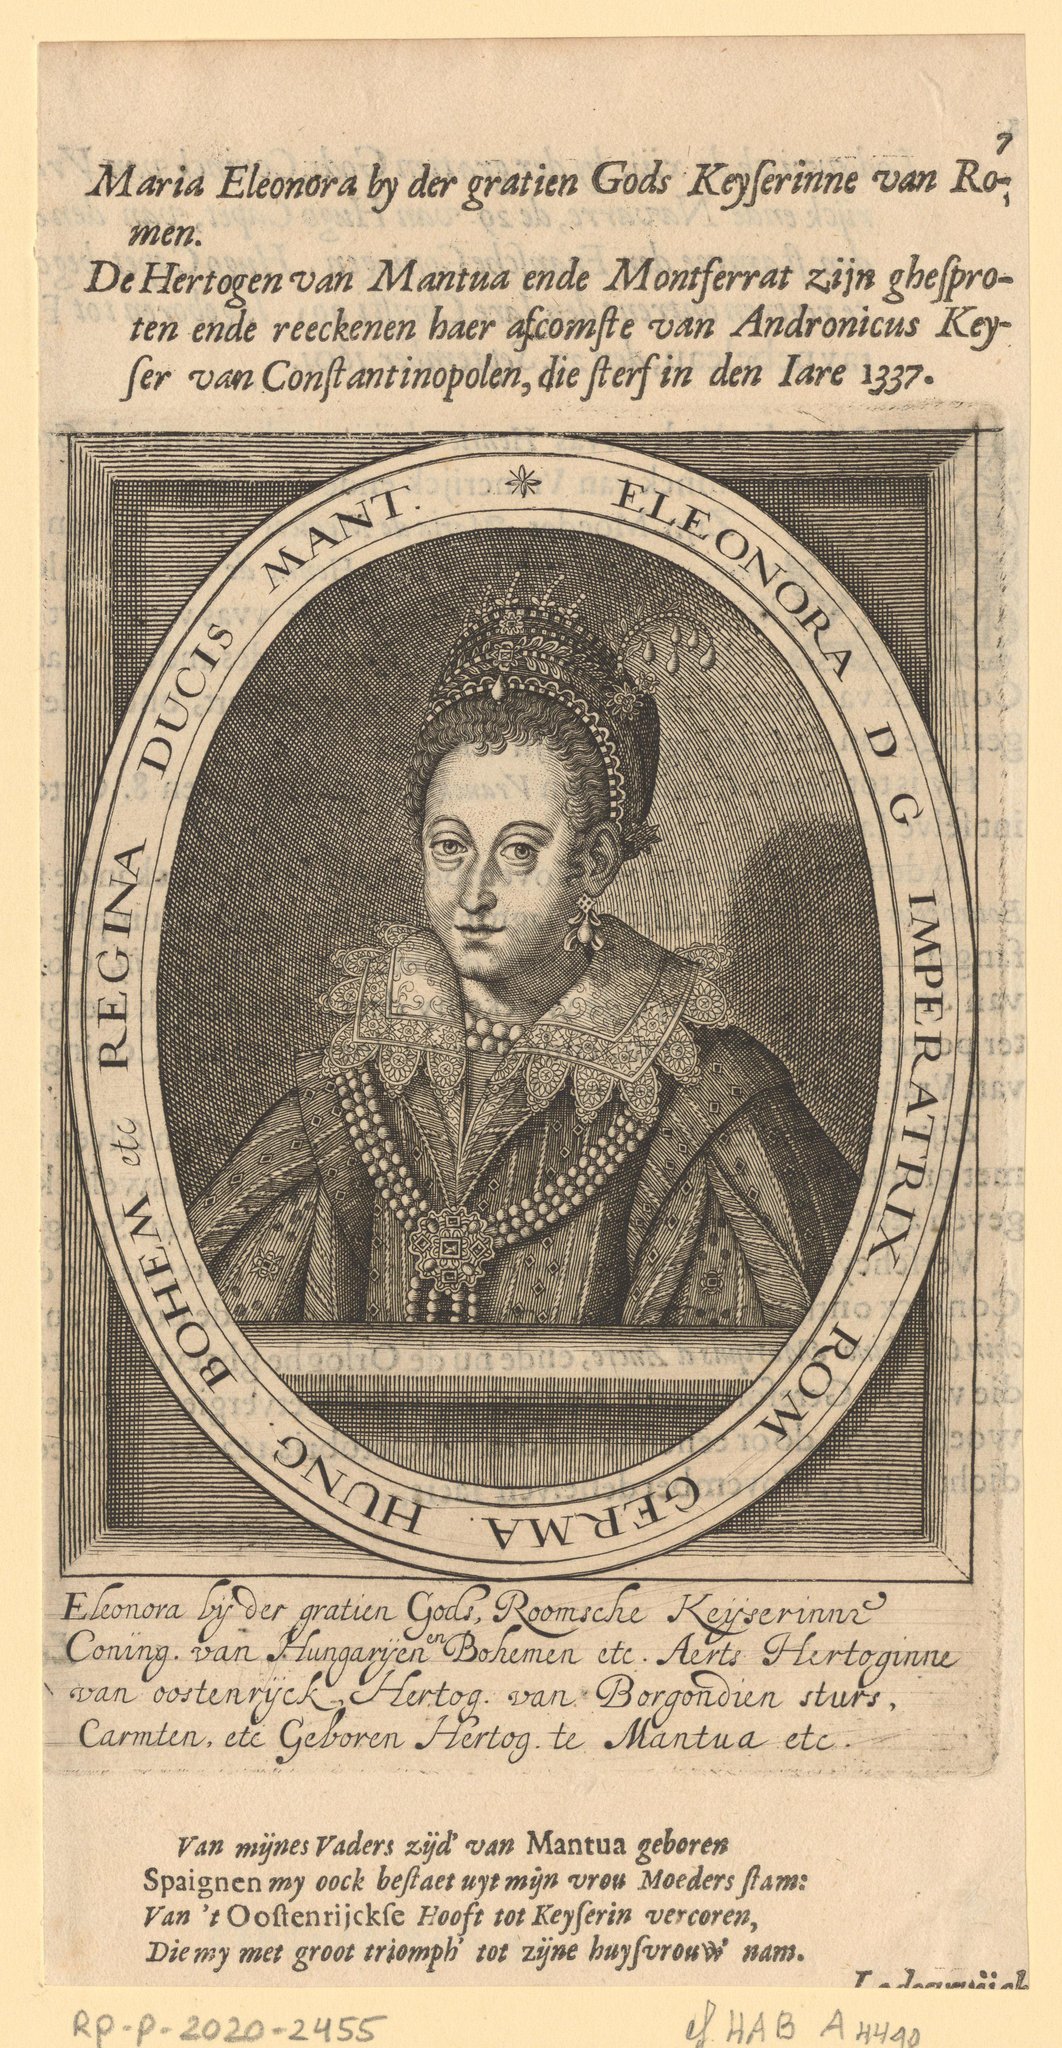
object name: book illustration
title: Portret van Eleonora Gonzaga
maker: Anonymous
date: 1630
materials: paper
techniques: engraving, letterpress printing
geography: northern netherlands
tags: crown (symbol of sovereignty), historical persons - bb - woman, pearl; pearl necklace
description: Prent gebruikt in meerdere edities en vertalingen van Emanuel van Meterens 'Nederlantsche Historiën'. Niet bekend uit welke editie dit portret komt, het portret met verschillende omlijstingen komt voor in edities uit 1630/1631.